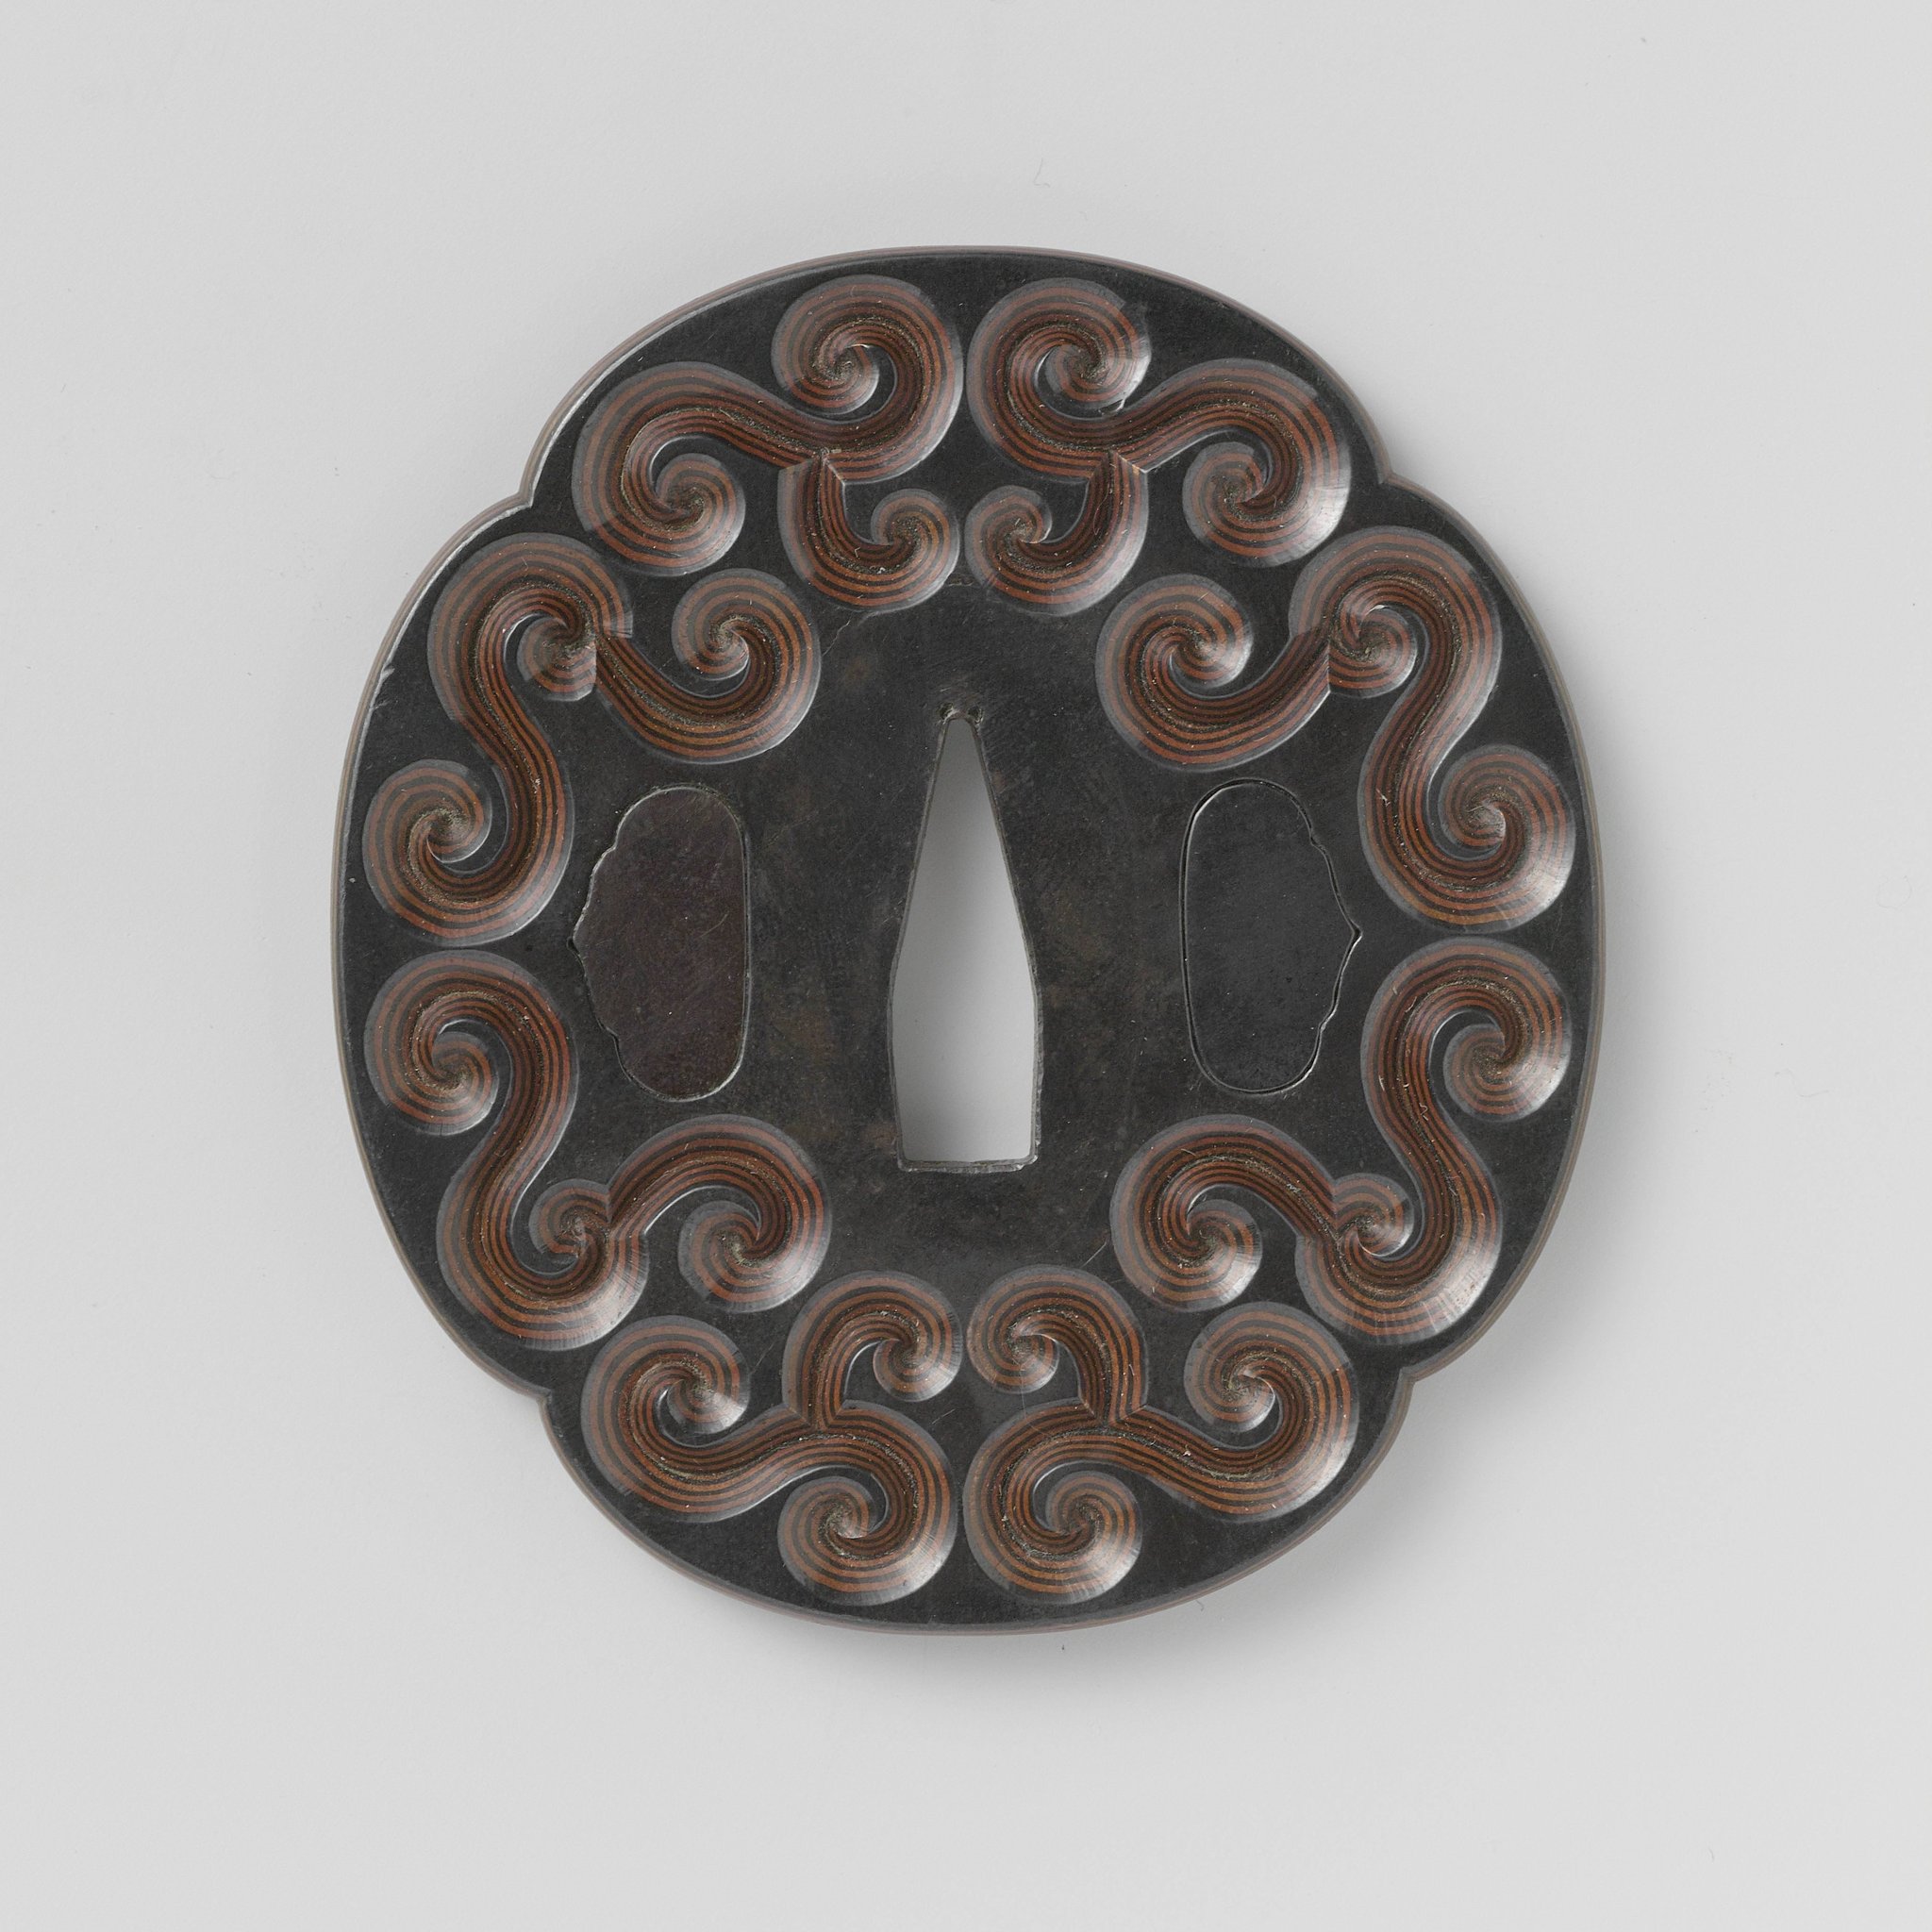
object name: tsuba, zwaardstootplaat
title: Hand guard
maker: Anonymous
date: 1700-1900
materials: copper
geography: japan